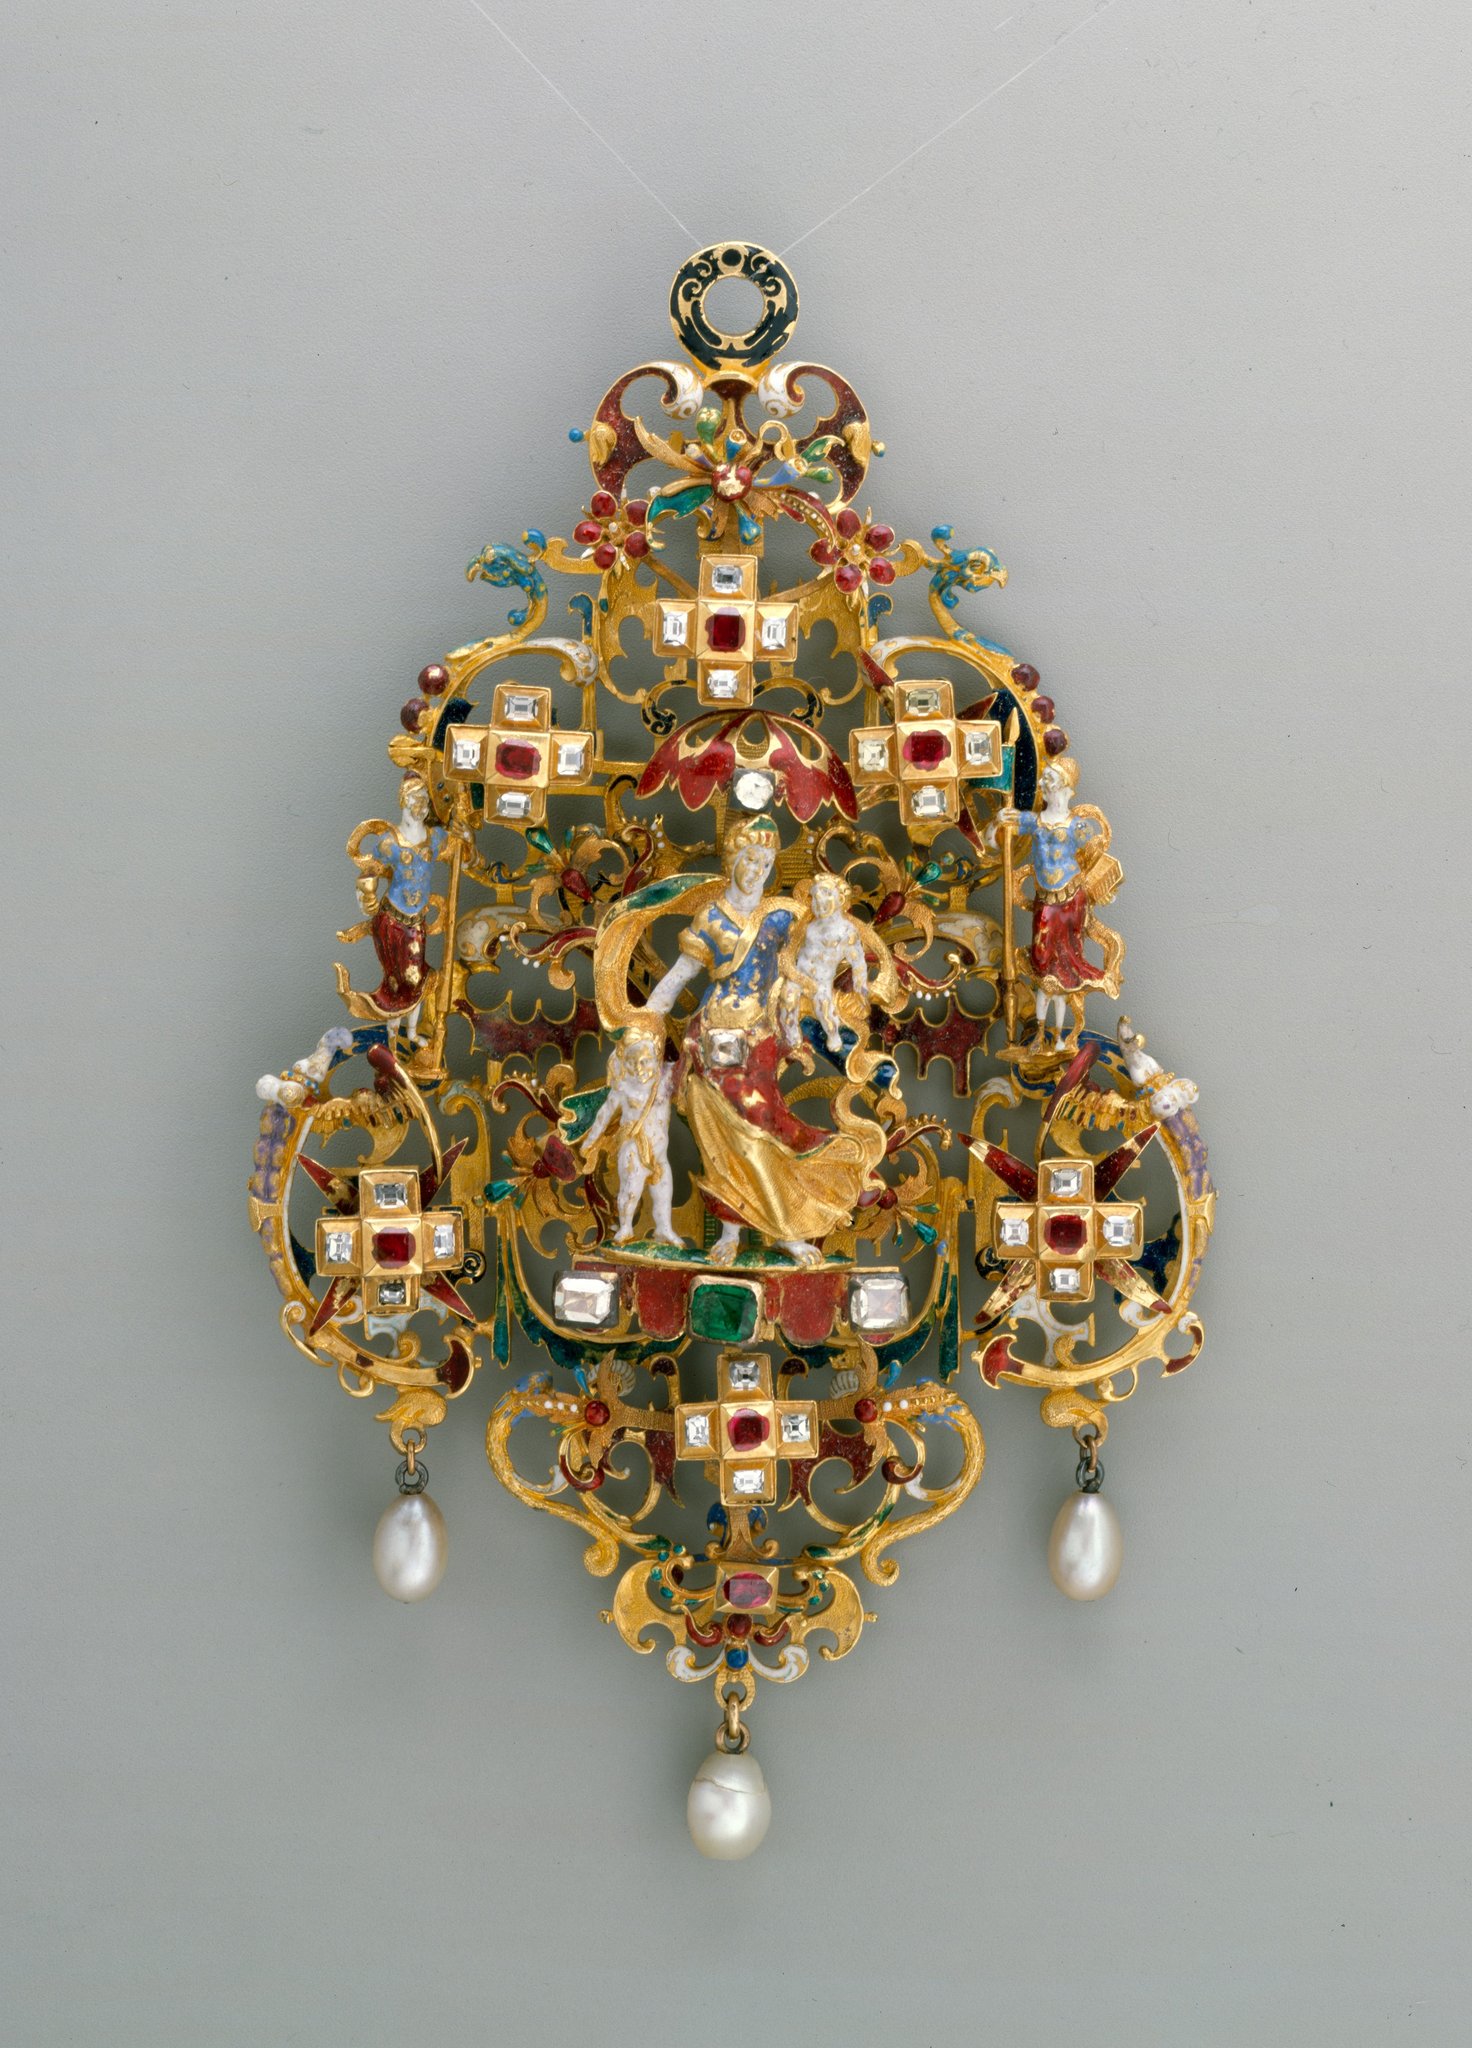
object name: pendant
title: Pendant with Charity and Her Children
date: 1567-1633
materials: diamond, gemstone, gold, pearl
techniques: enamel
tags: children,women